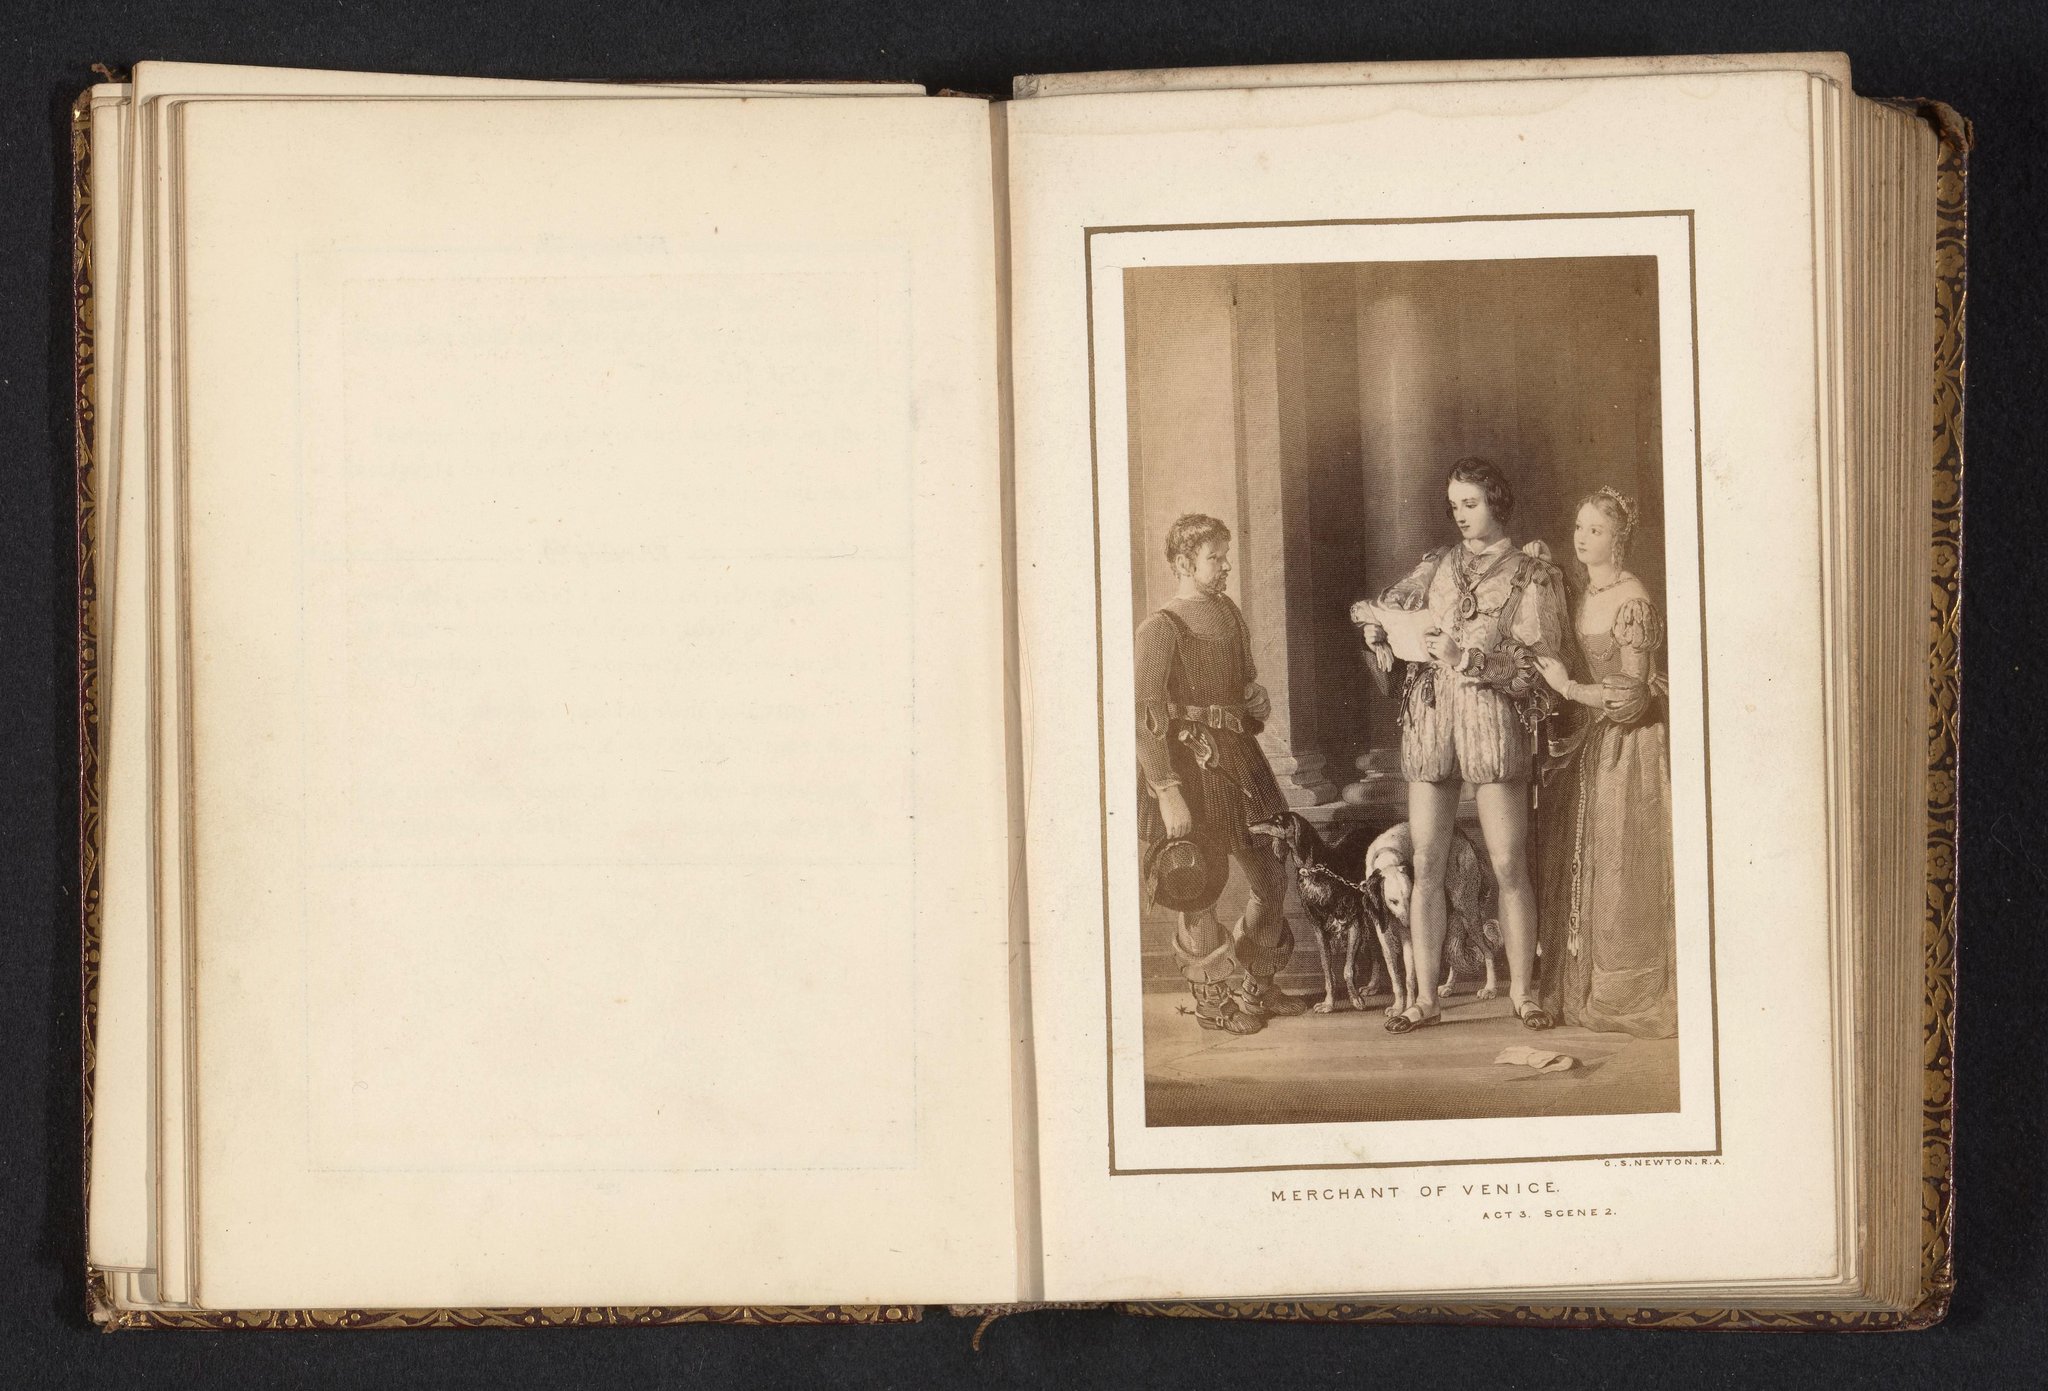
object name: reproduction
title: Merchant of Venice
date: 1866-1876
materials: photographic support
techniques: albumen print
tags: reading, specific works of literature, the arts of the stage: ballet, theatre, musical drama, motion picture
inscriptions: inscription: ‘Act 3. scene 2.’